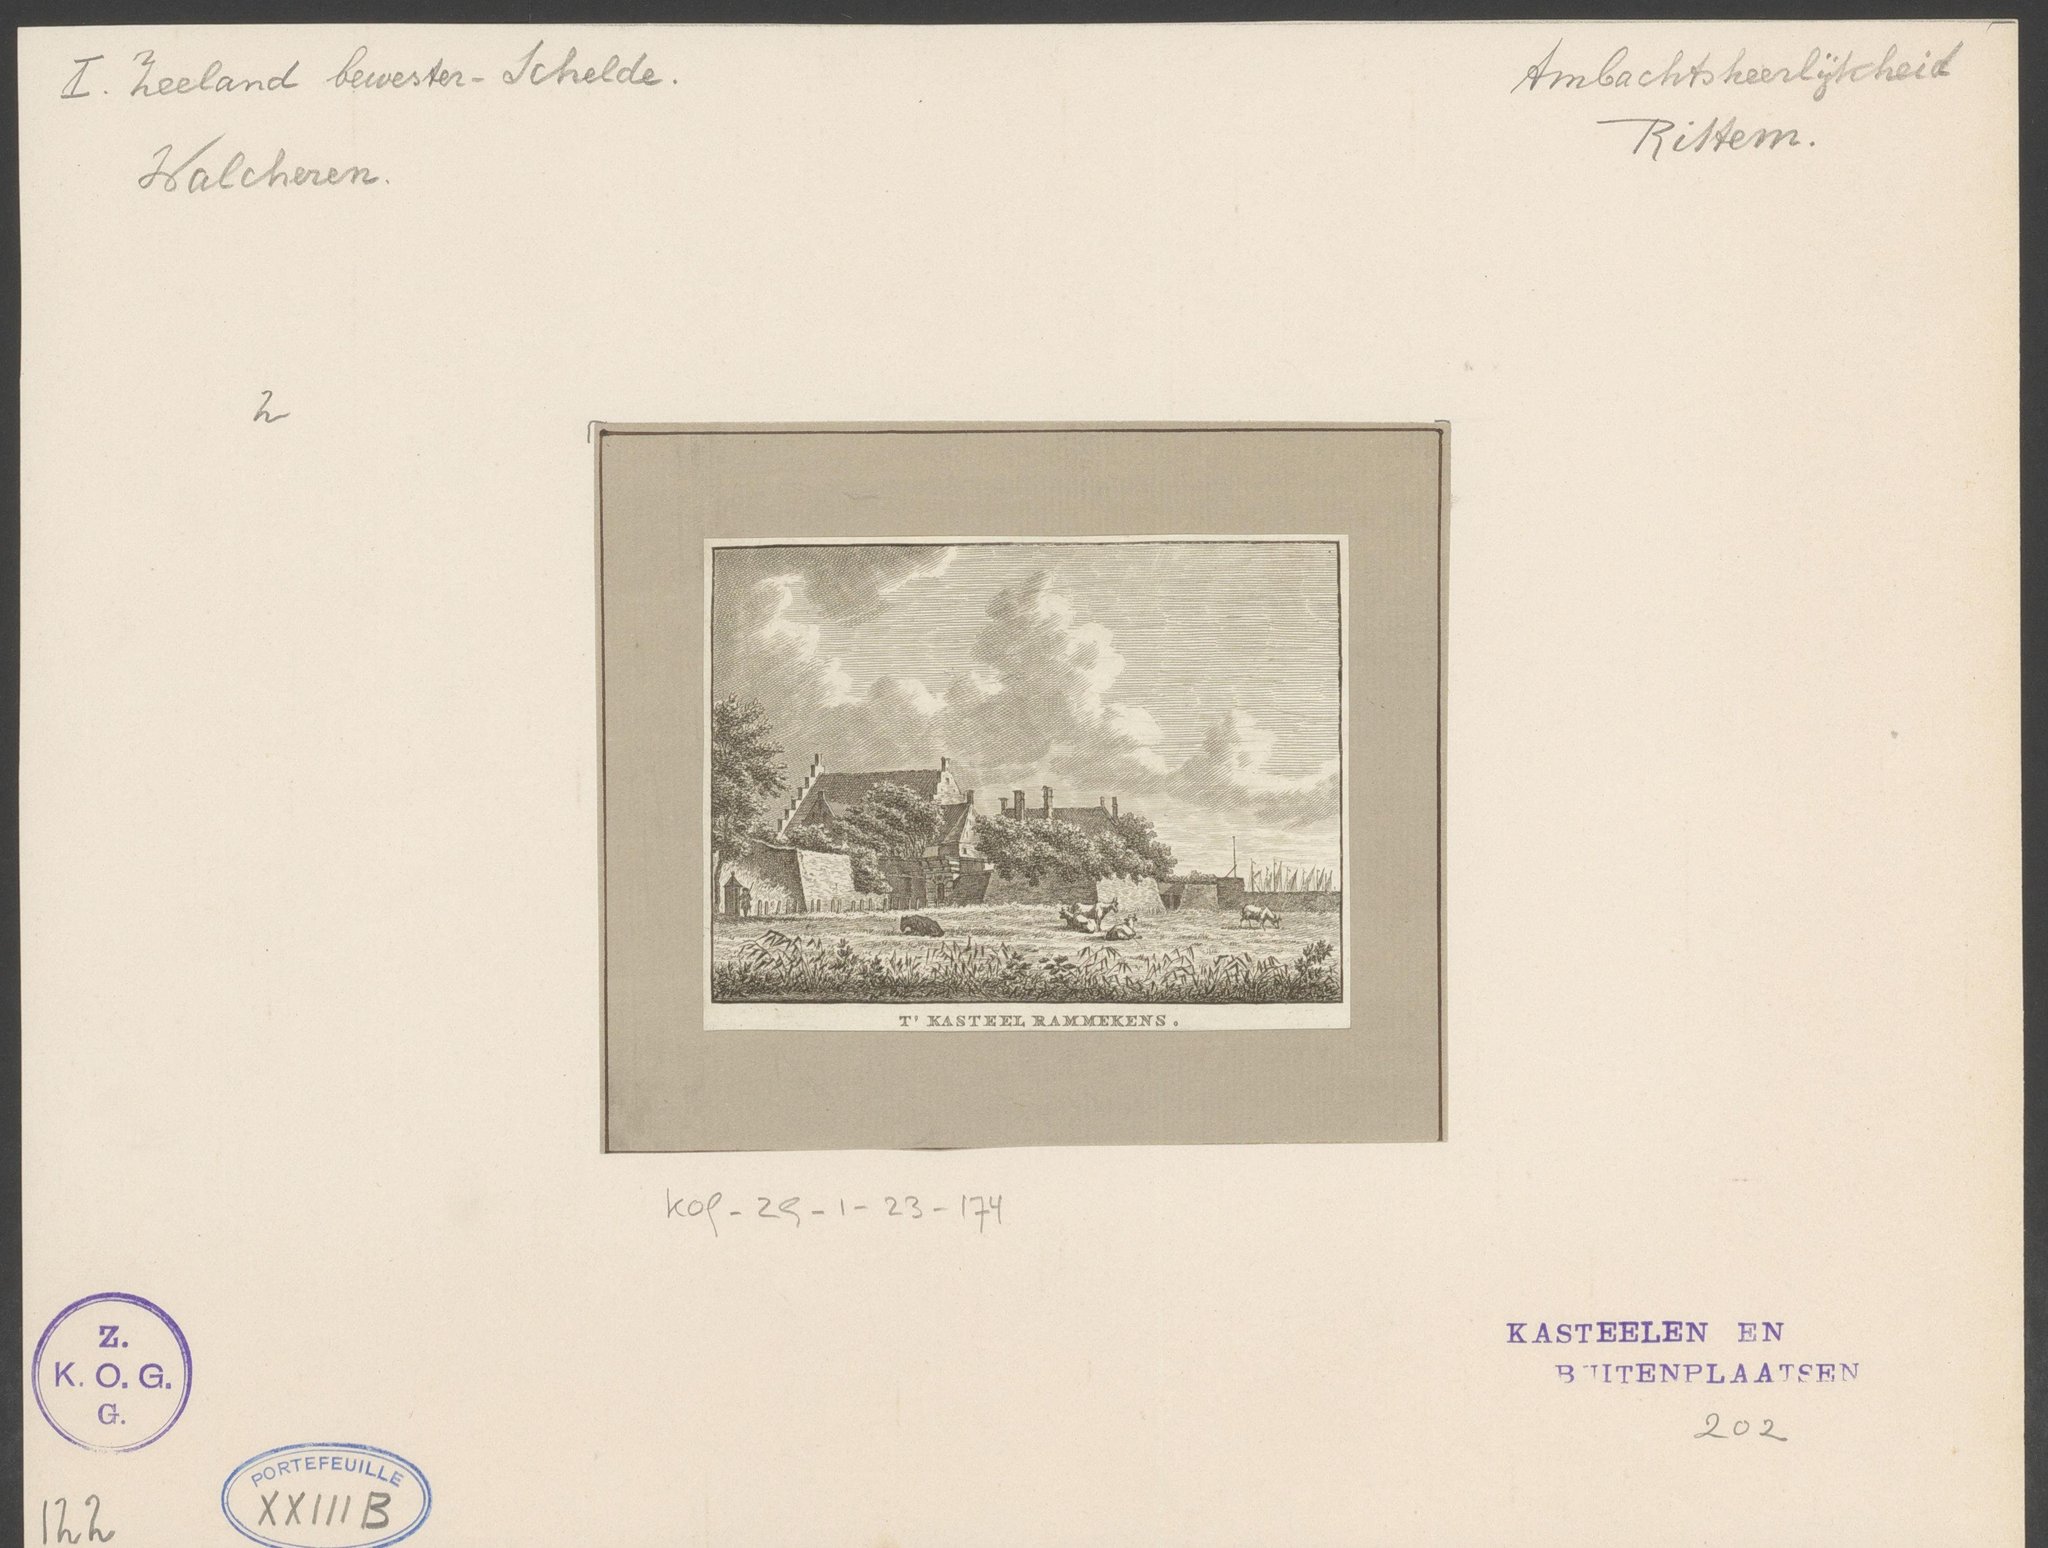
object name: print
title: Gezicht op fort Rammekens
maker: carel frederik bendorp (i)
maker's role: print maker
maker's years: 1736-1814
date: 1786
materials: paper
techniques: engraving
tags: castle, meadow, pasture, sheep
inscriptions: collector's mark: Lugt 1641, stamp, stamp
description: Prent mogelijk uit: Vaderlandsche gezichten, of afbeeldingen van den tegenwoordigen staat der Vereenigde Nederlanden (…). Amsterdam: Hendrik Gartman, Willem Vermandel en Jan Willem Smit, 1786-1792, dl. 3 (1786). Uitgegeven in afleveringen met ieder een eigen bifolium en inhoudsopgave. Alle prenten in deze publicatie zijn gegraveerd door Carel Frederik Bendorp (I) en, in de meeste gevallen, gebaseerd op tekeningen van Jan Bulthuis.